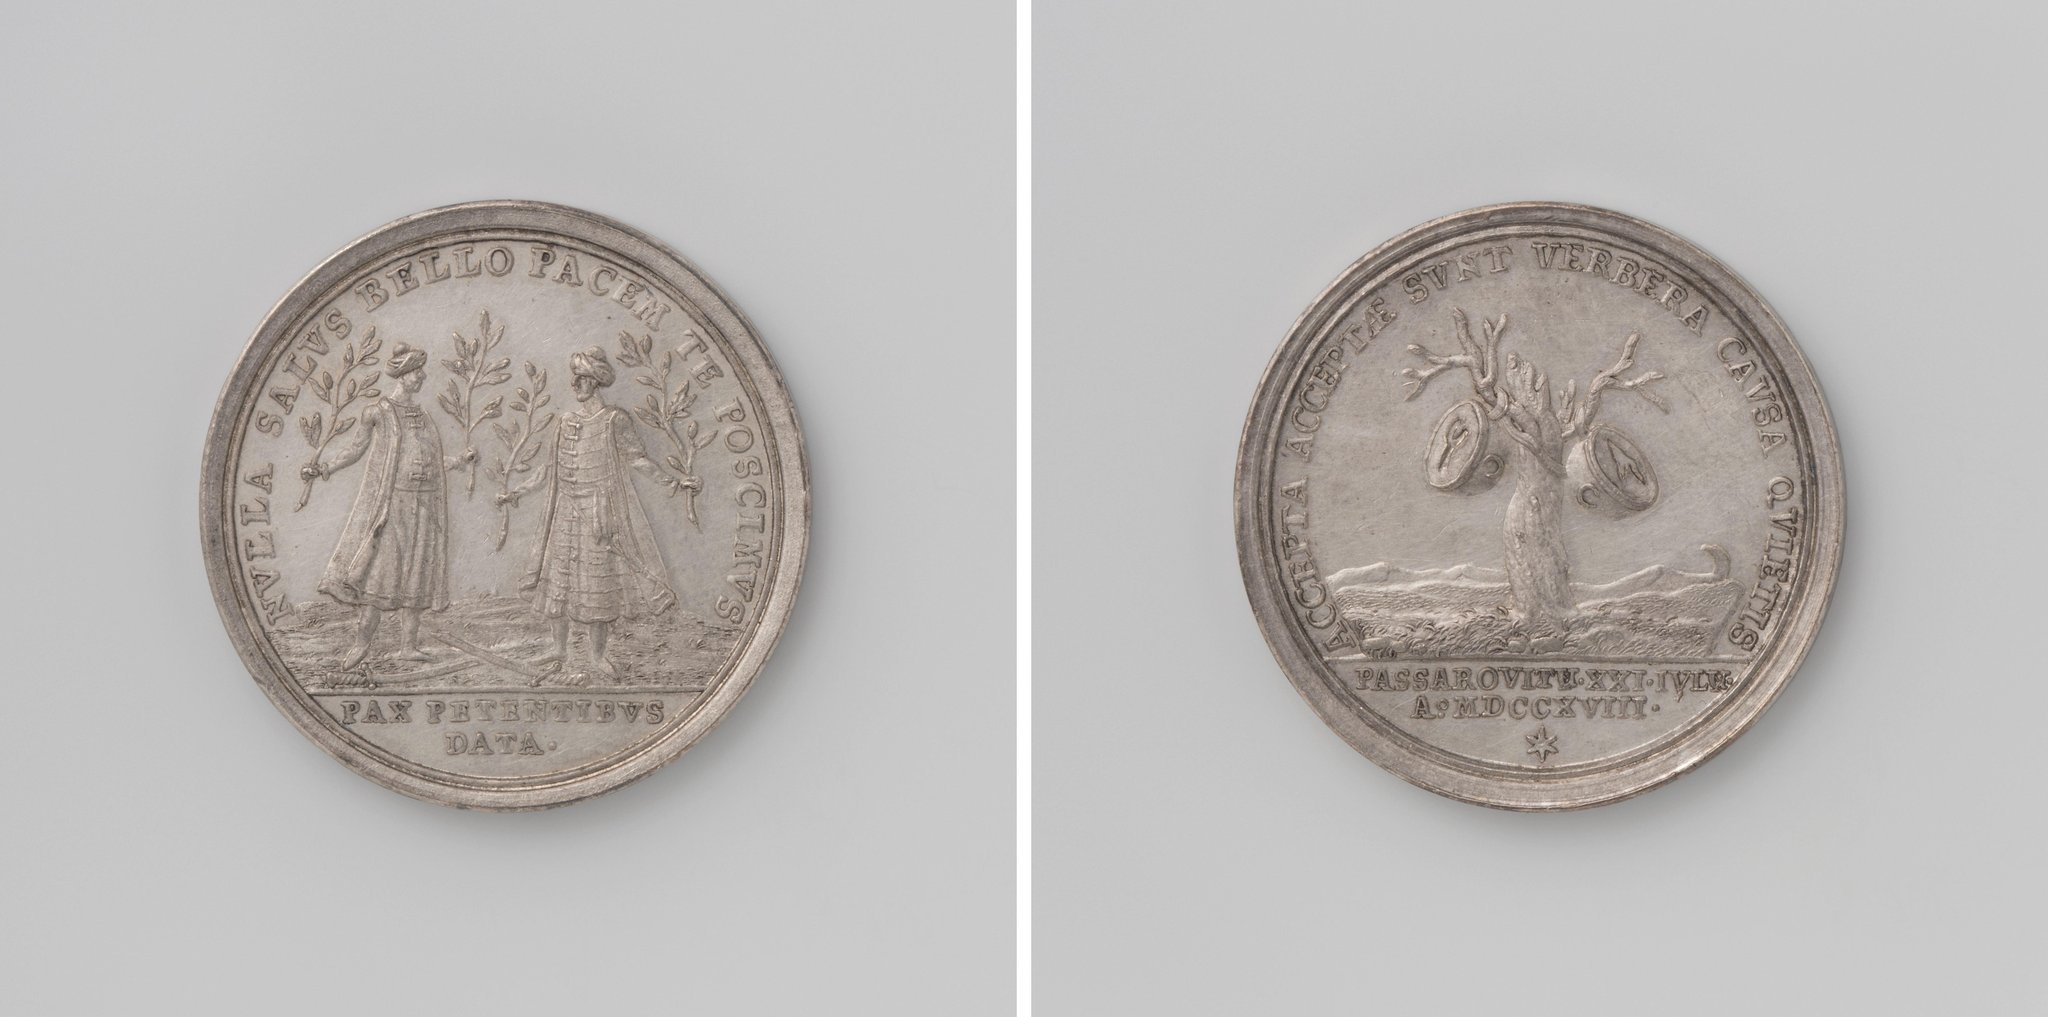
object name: history medal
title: Vrede te Passarowitz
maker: georg wilhelm vestner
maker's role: medailleur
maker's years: 1677-1740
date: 1718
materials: silver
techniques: striking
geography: nuremberg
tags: servië, pozarevac, oorlog tegen de turken (1716-1718), vrede van passarowitz (1718)